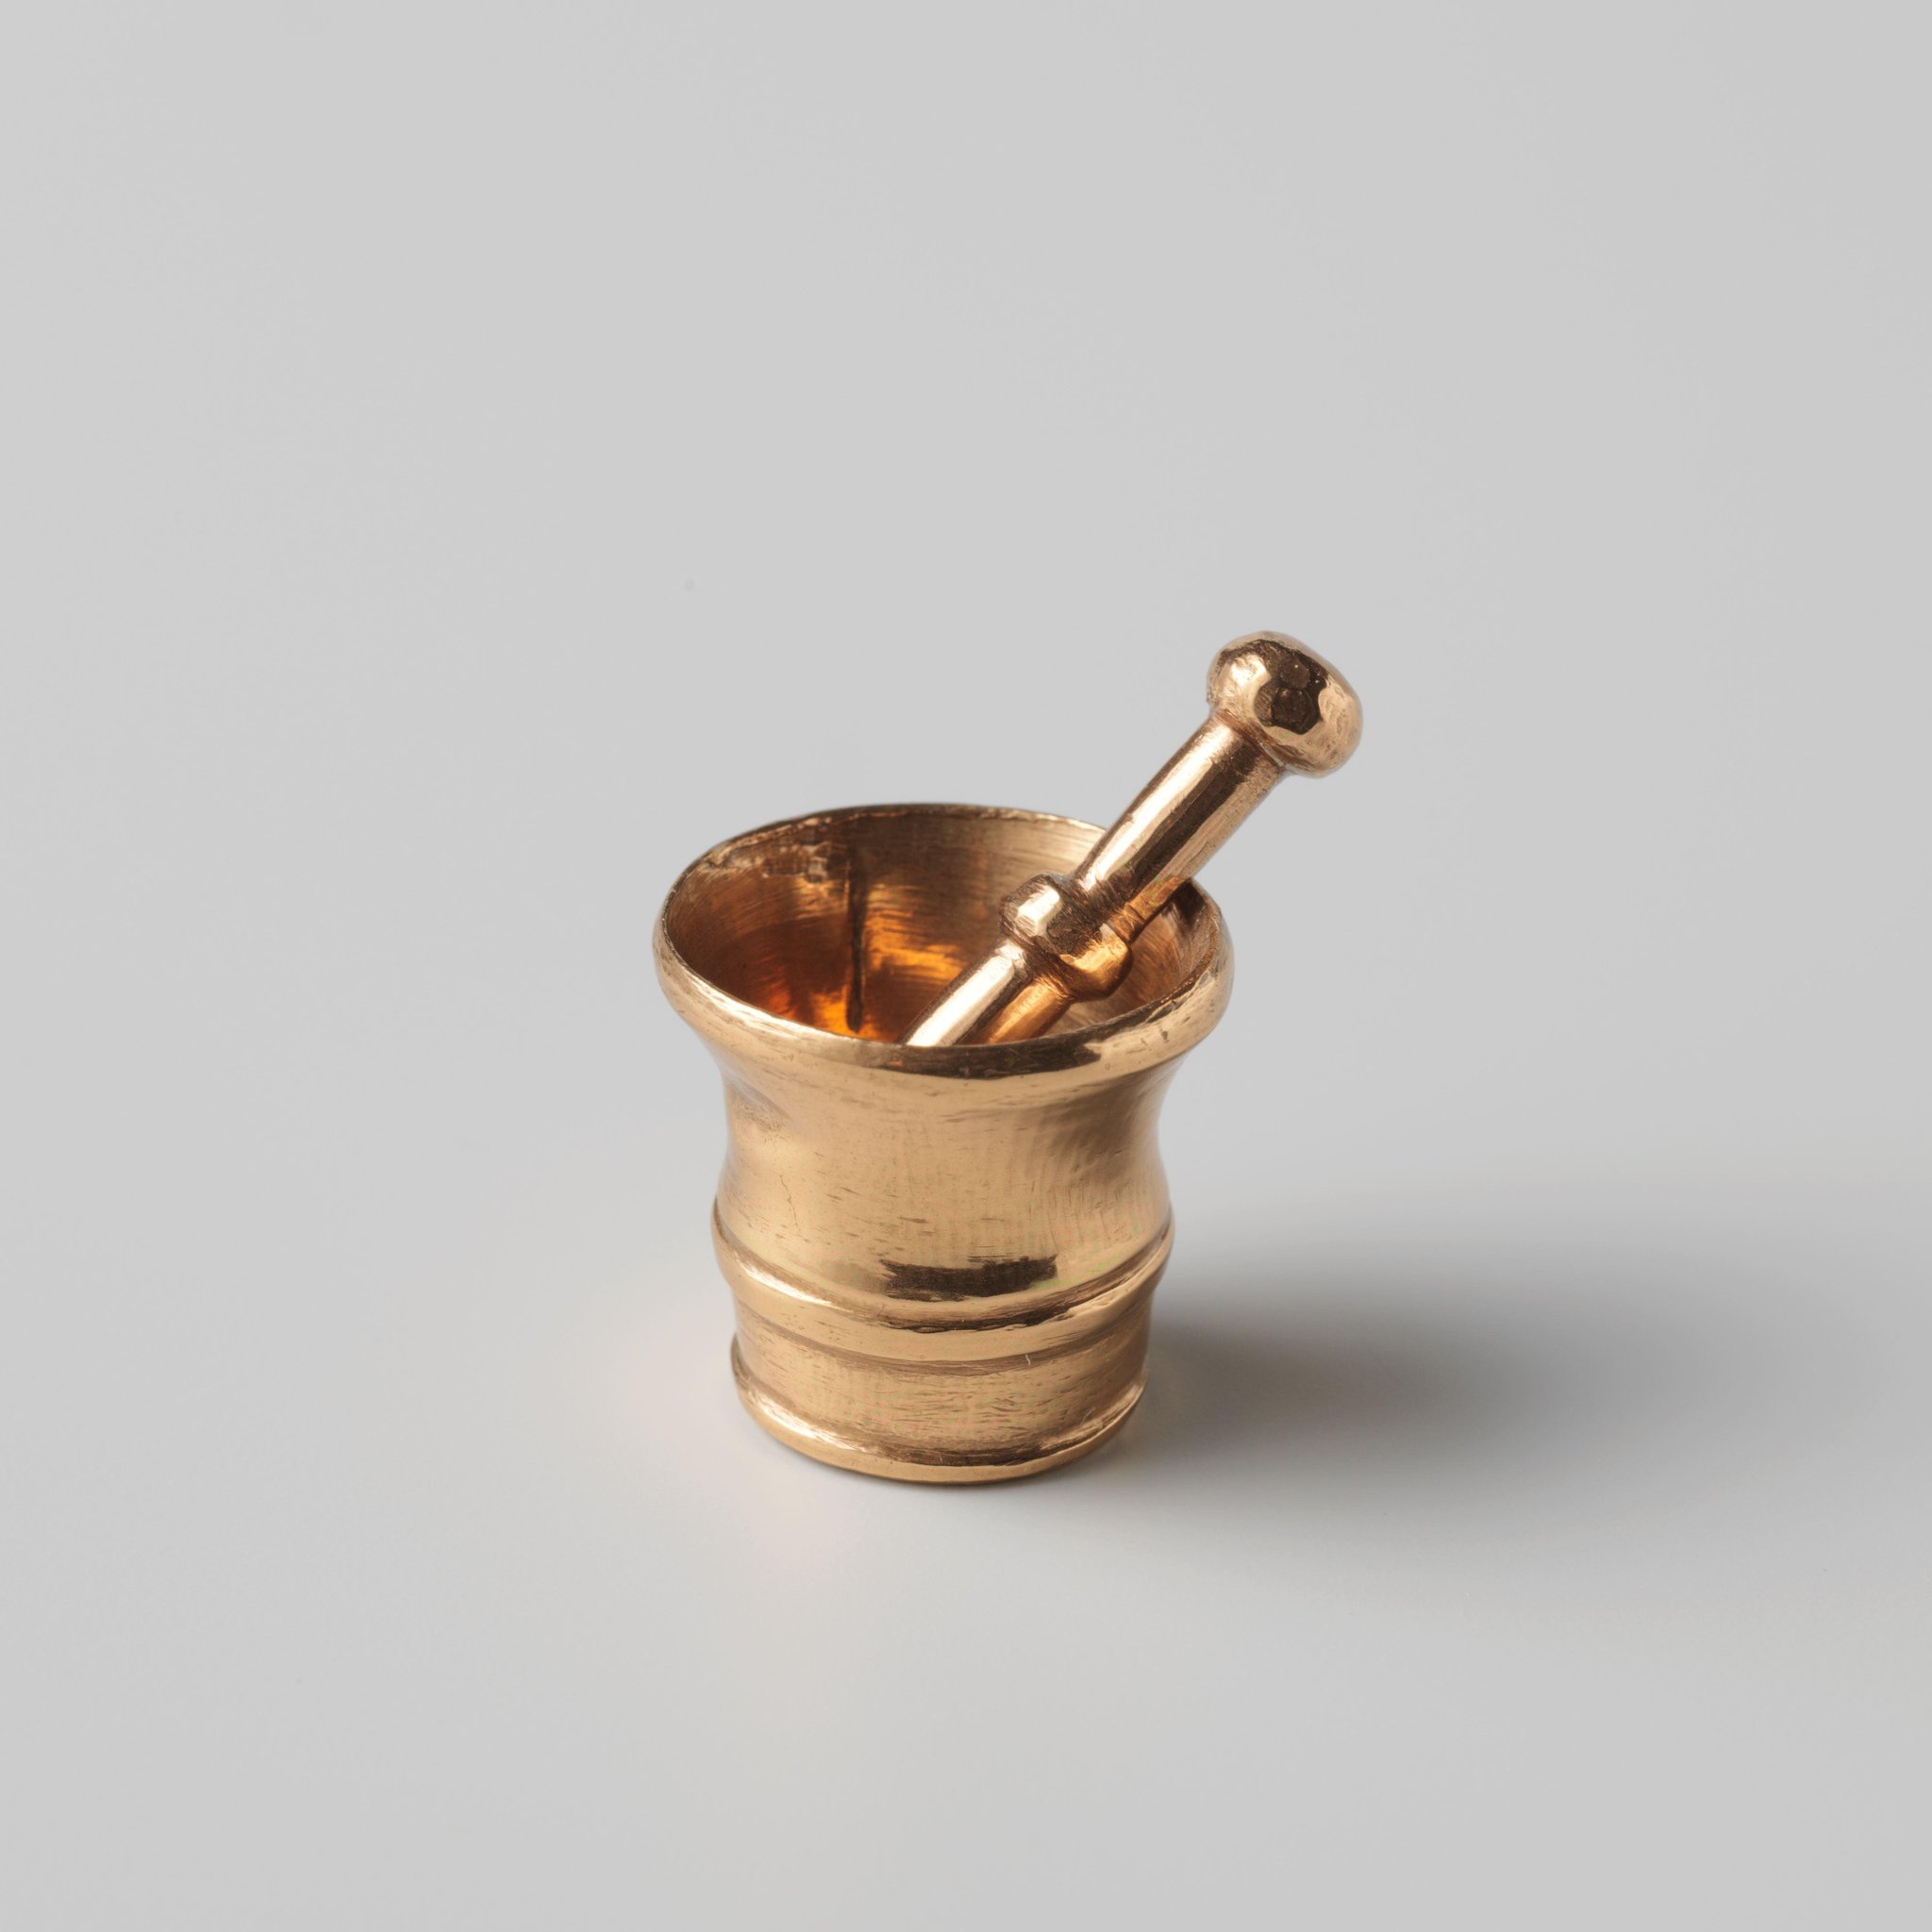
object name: mortar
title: Vijzel met stamper, met bandversiering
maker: Anonymous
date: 1700-1799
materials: brass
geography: amsterdam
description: Vijzel van geelkoper met bandversiering; stamper met drie knopen.